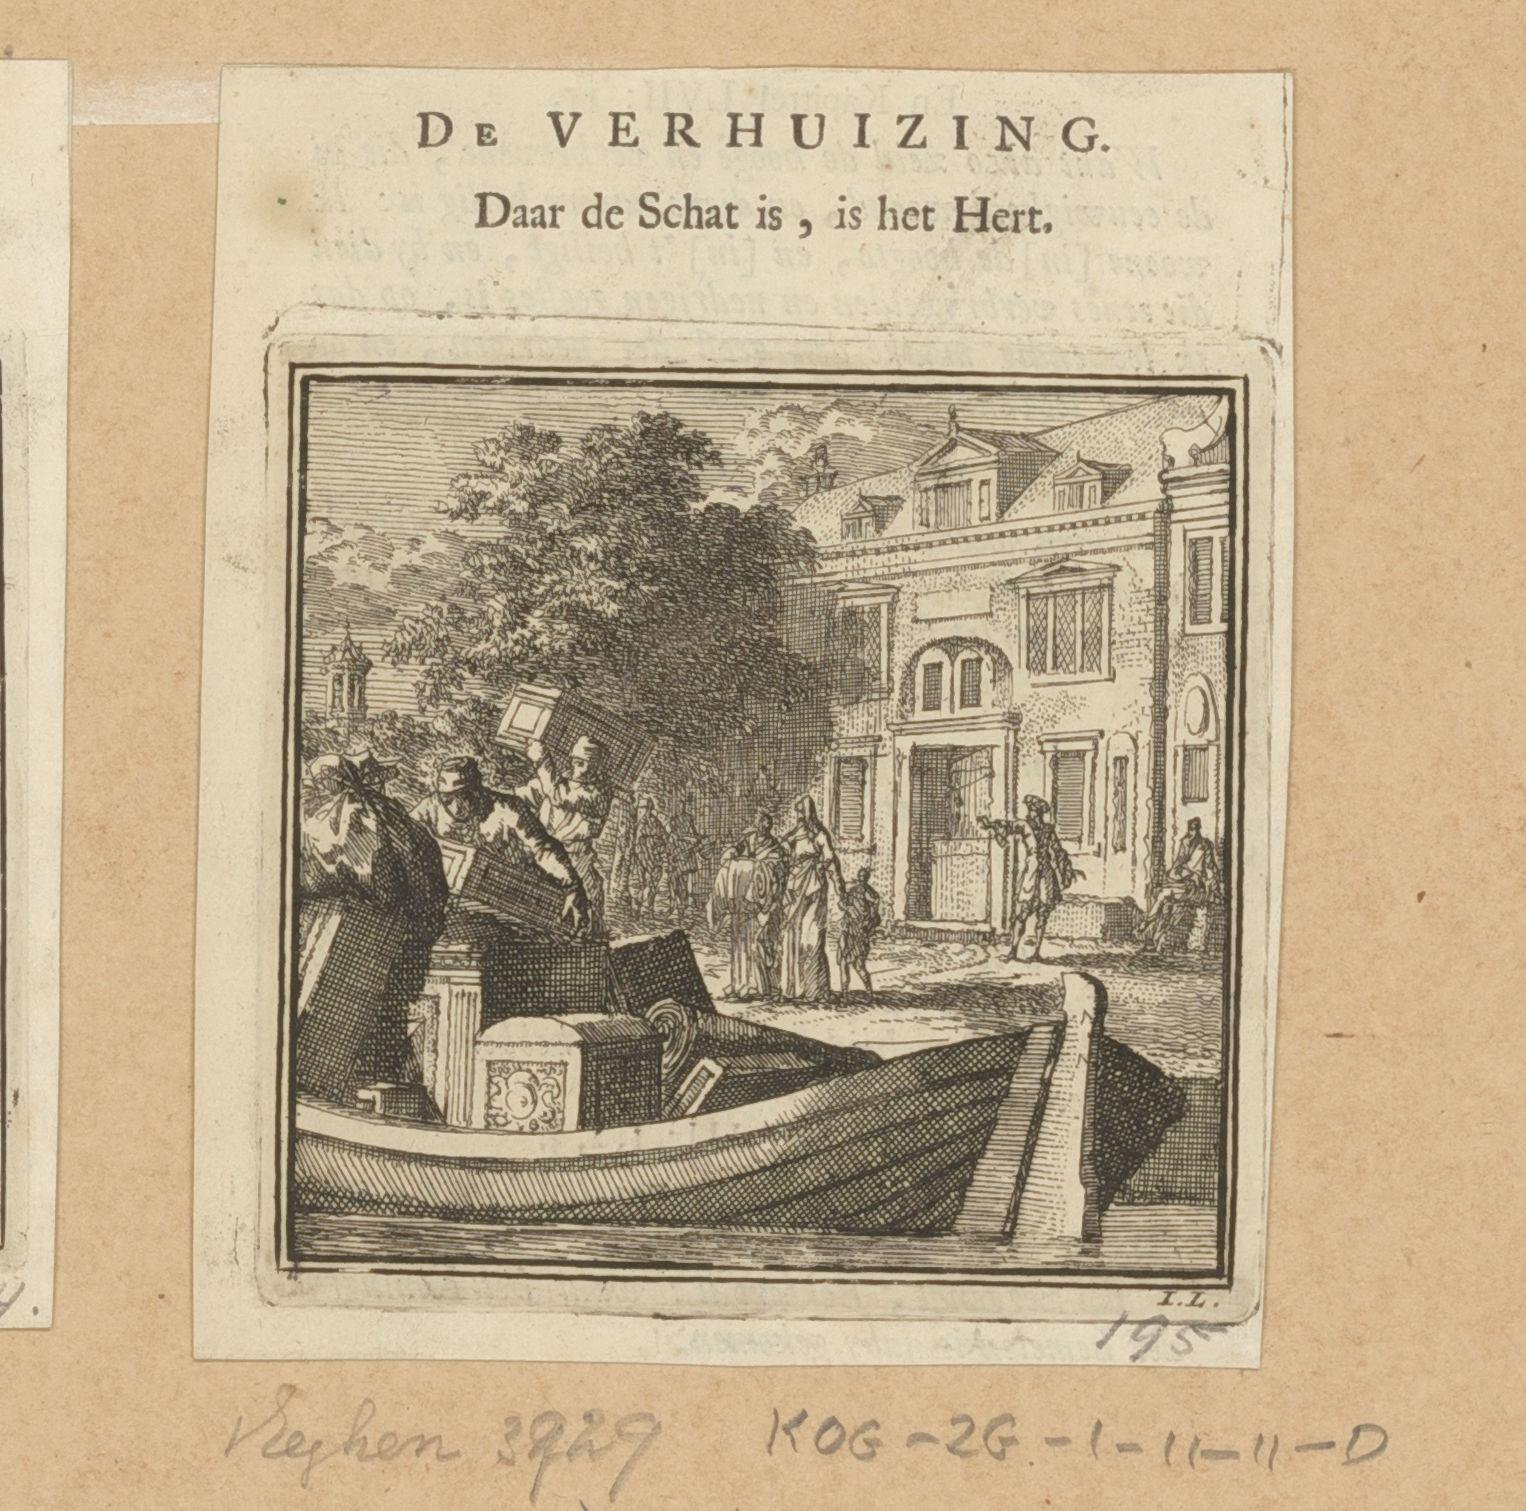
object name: print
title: Verhuizing per schip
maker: jan luyken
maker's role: draughtsman, print maker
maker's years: 1649-1712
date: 1709-1711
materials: paper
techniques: etching, letterpress printing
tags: moving (house), ships (in general)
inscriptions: collector's mark: Lugt 1641, stamp, stamp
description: Verhuizing de huisraad wordt op een schip geladen. Onderwerpsrubrieken binnen de Atlas Zeden en Gewoonten: Handel, nijverheid en verkeer, Vervoermiddelen te land en te water, Vervoermiddelen te water.